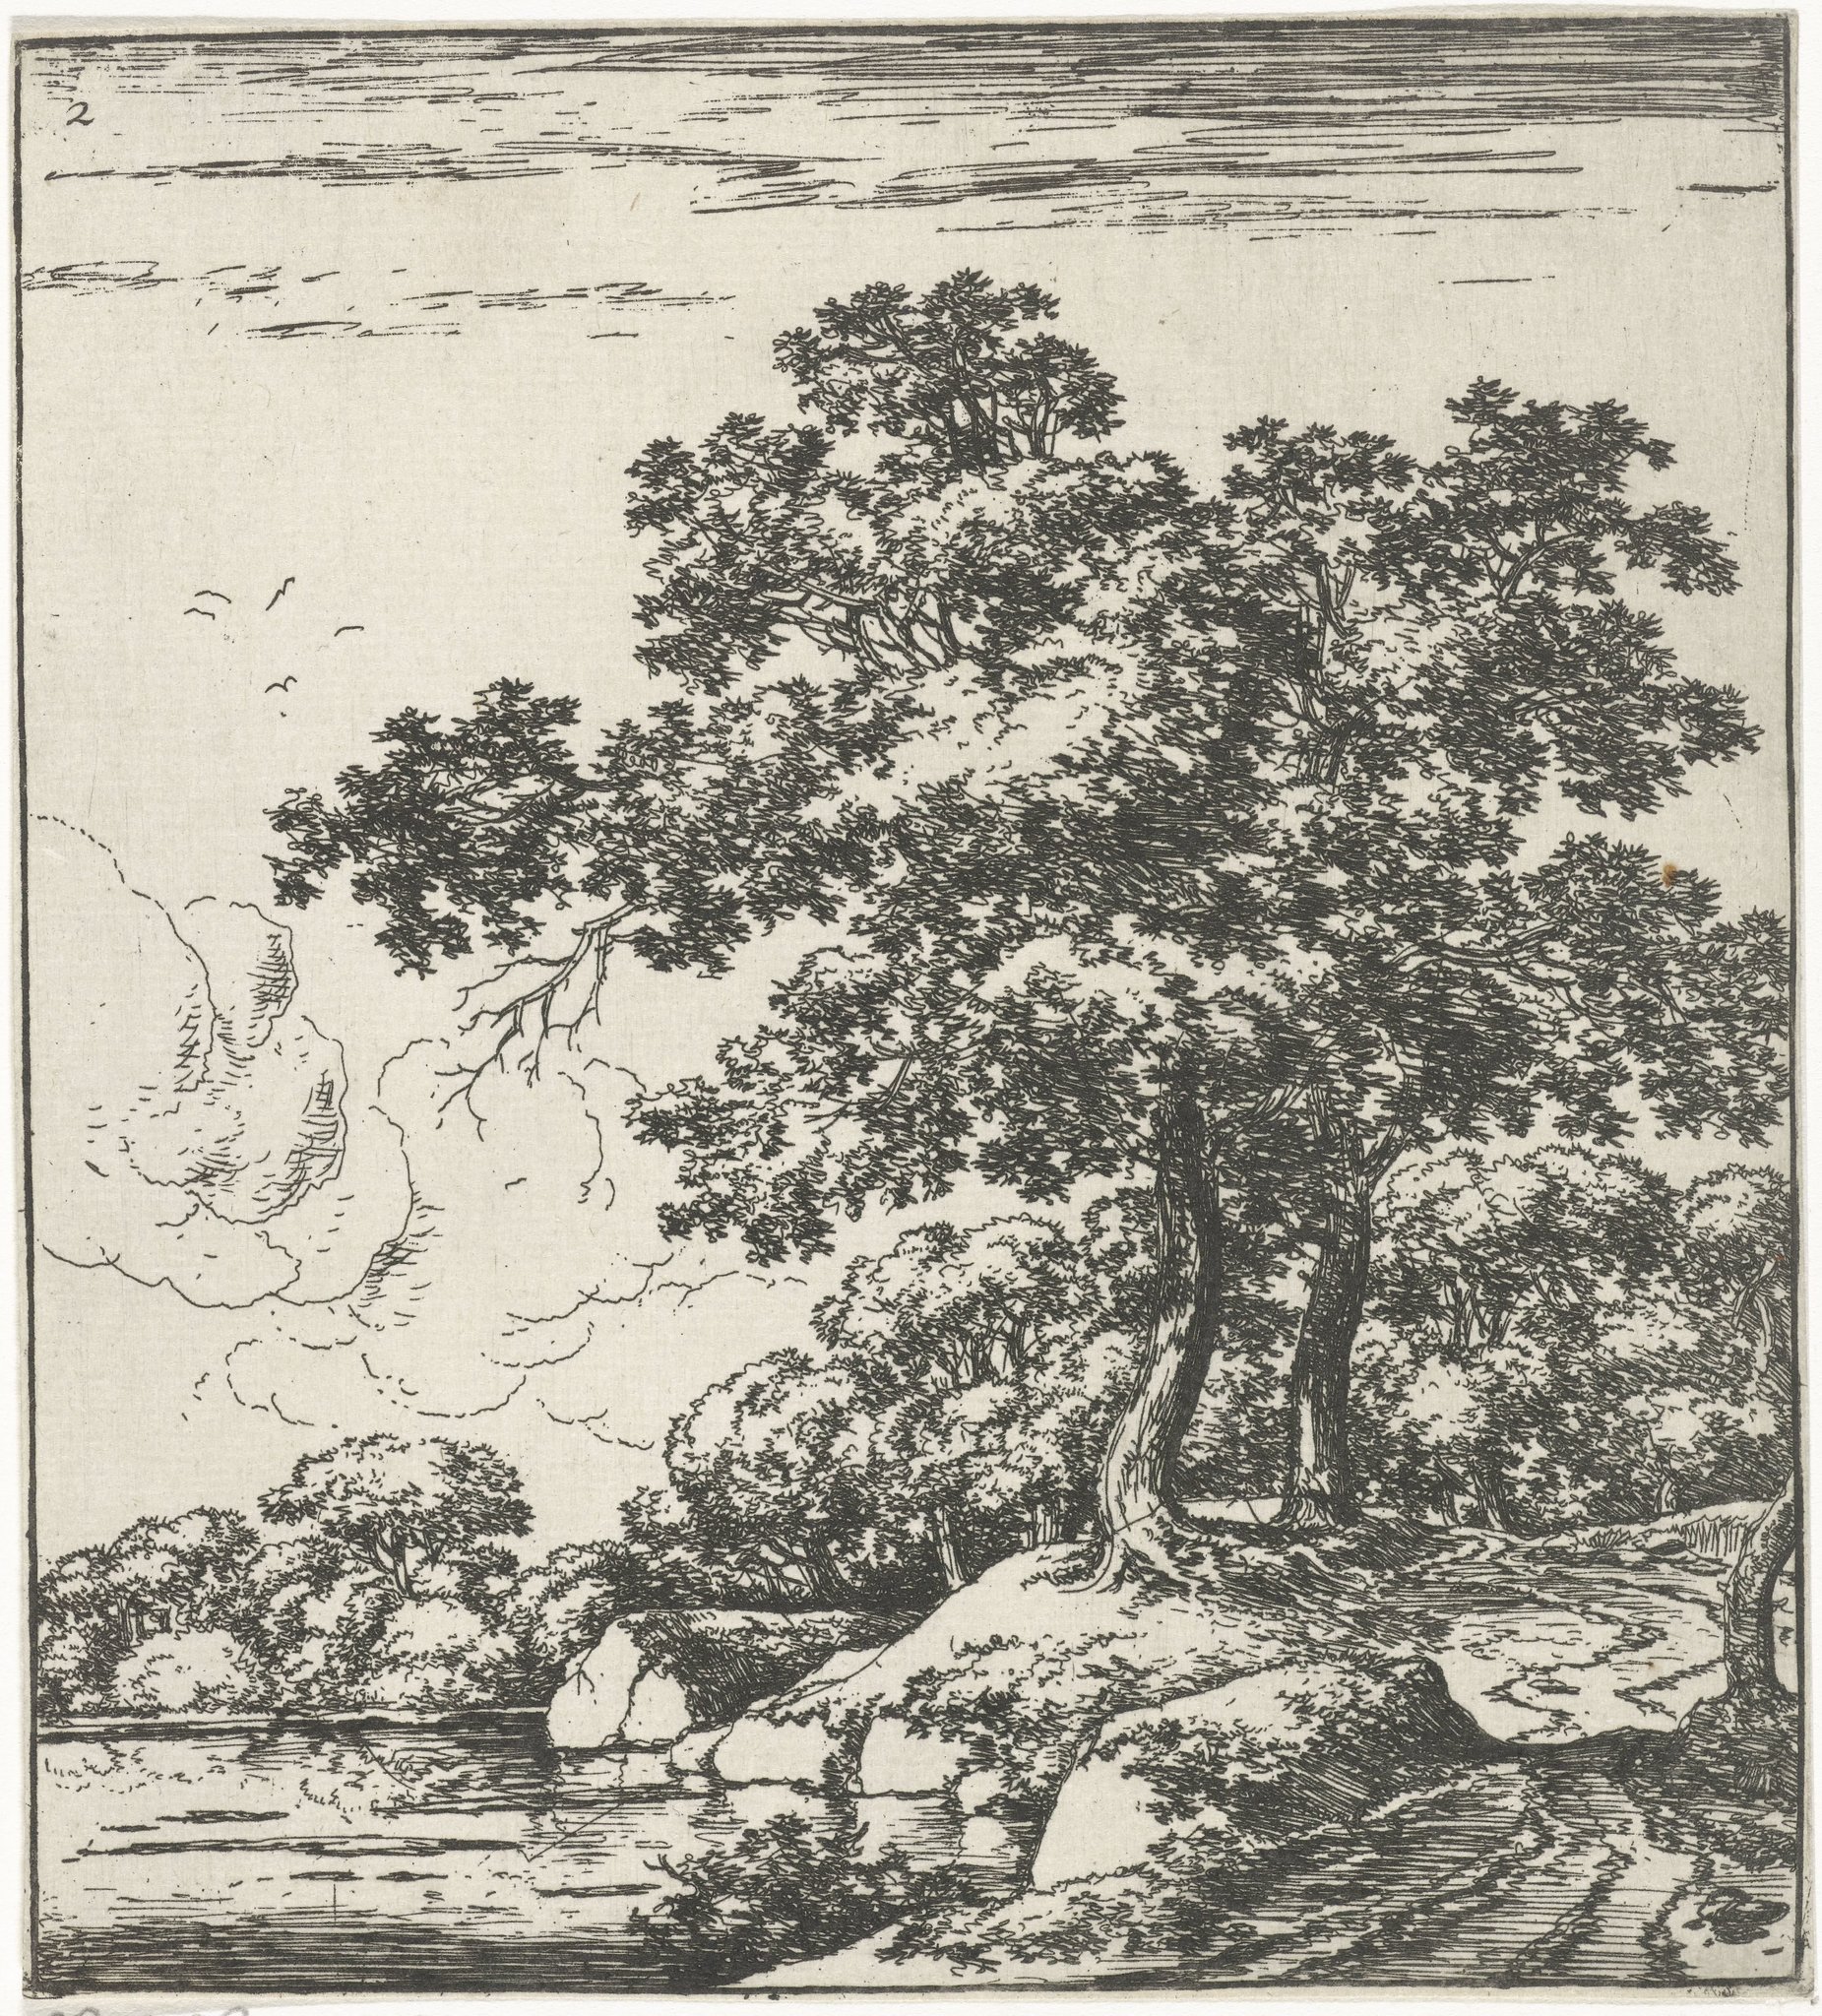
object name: print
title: Serie 2: Landschappen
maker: herman naiwincx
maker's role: draughtsman, print maker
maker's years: 1623-1670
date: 1633-1670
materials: paper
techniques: etching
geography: amsterdam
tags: trees, river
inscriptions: collector's mark: Lugt 240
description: Rechts op de rivieroever twee grote bomen.